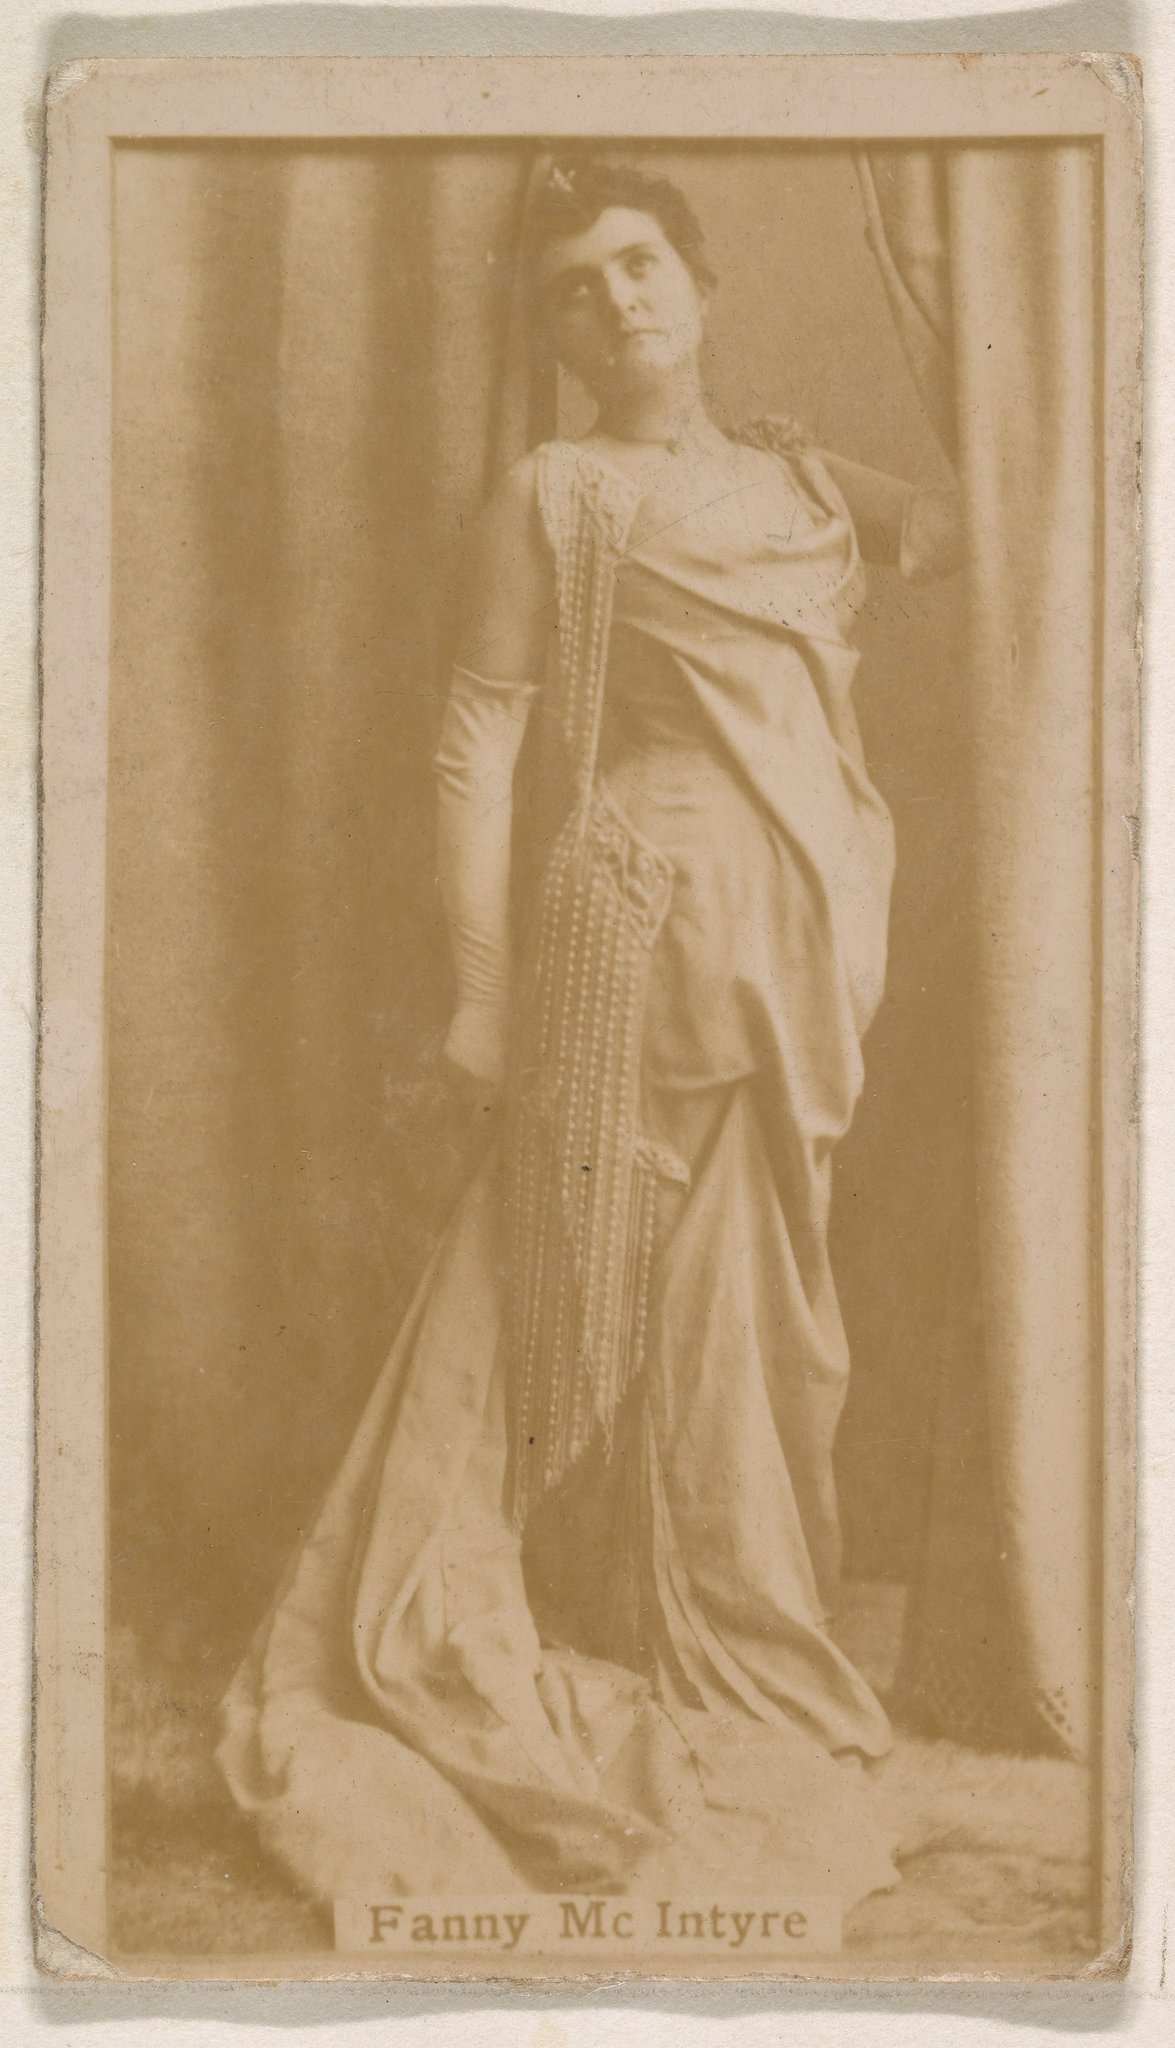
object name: photograph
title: Fanny McIntyre, from the Actresses series (N245) issued by Kinney Brothers to promote Sweet Caporal Cigarettes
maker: kinney brothers tobacco company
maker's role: publisher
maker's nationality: american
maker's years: 1869-2011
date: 1890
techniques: albumen silver print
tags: portraits,women,actresses